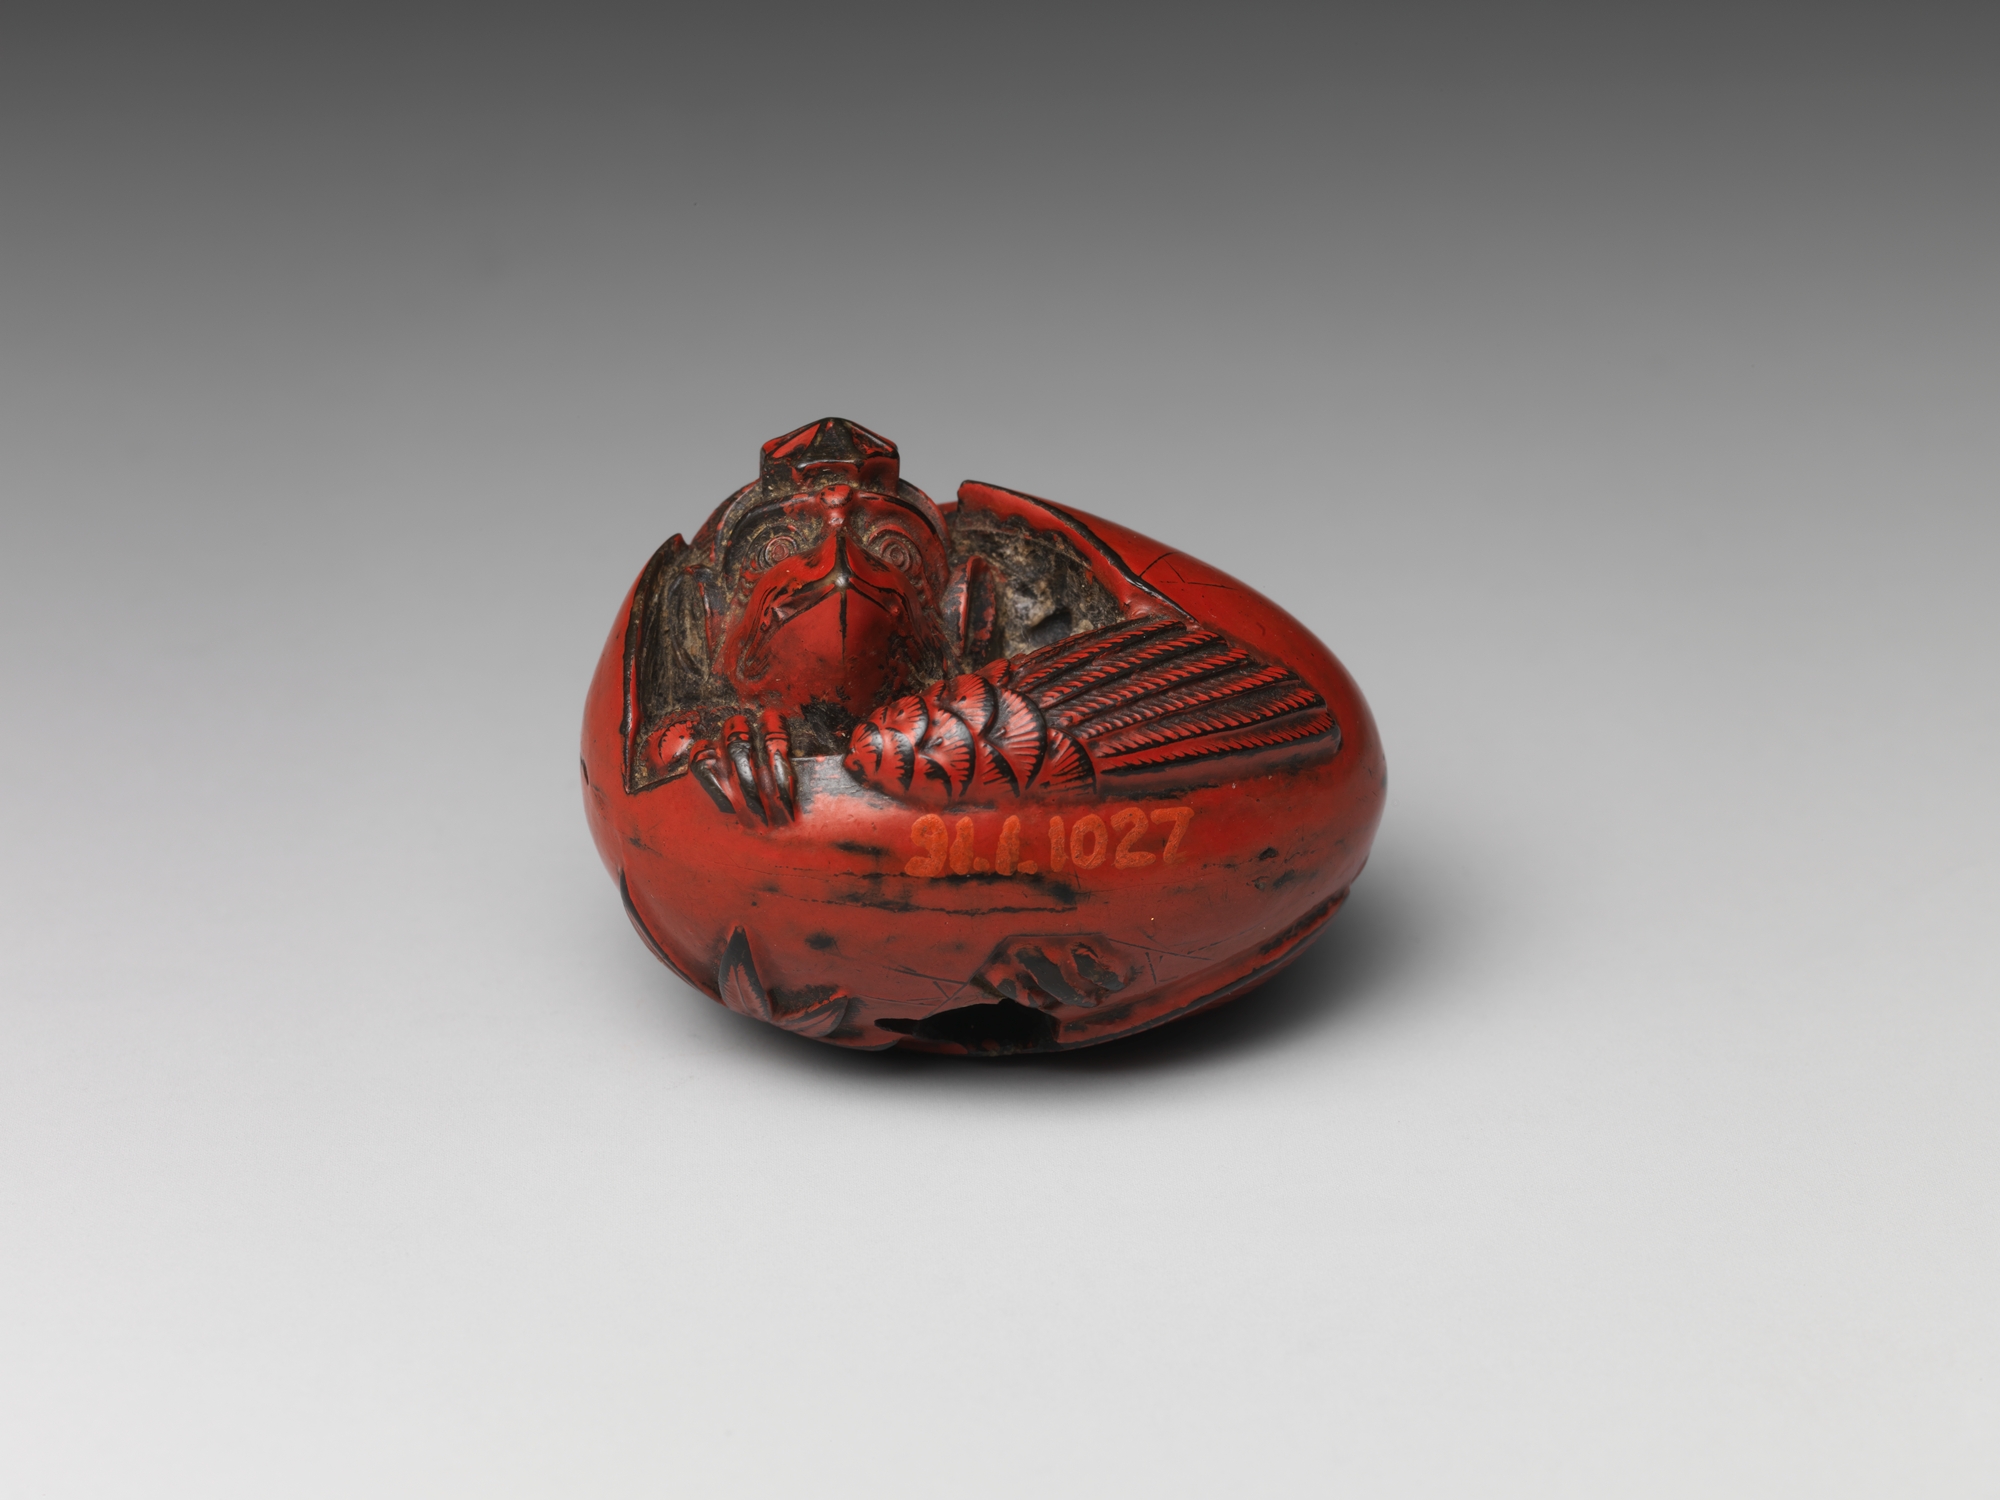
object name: netsuke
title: Tengu Hatching from an Egg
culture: japanese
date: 1701-1800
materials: lacquer, wood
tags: mythical creatures,eggs